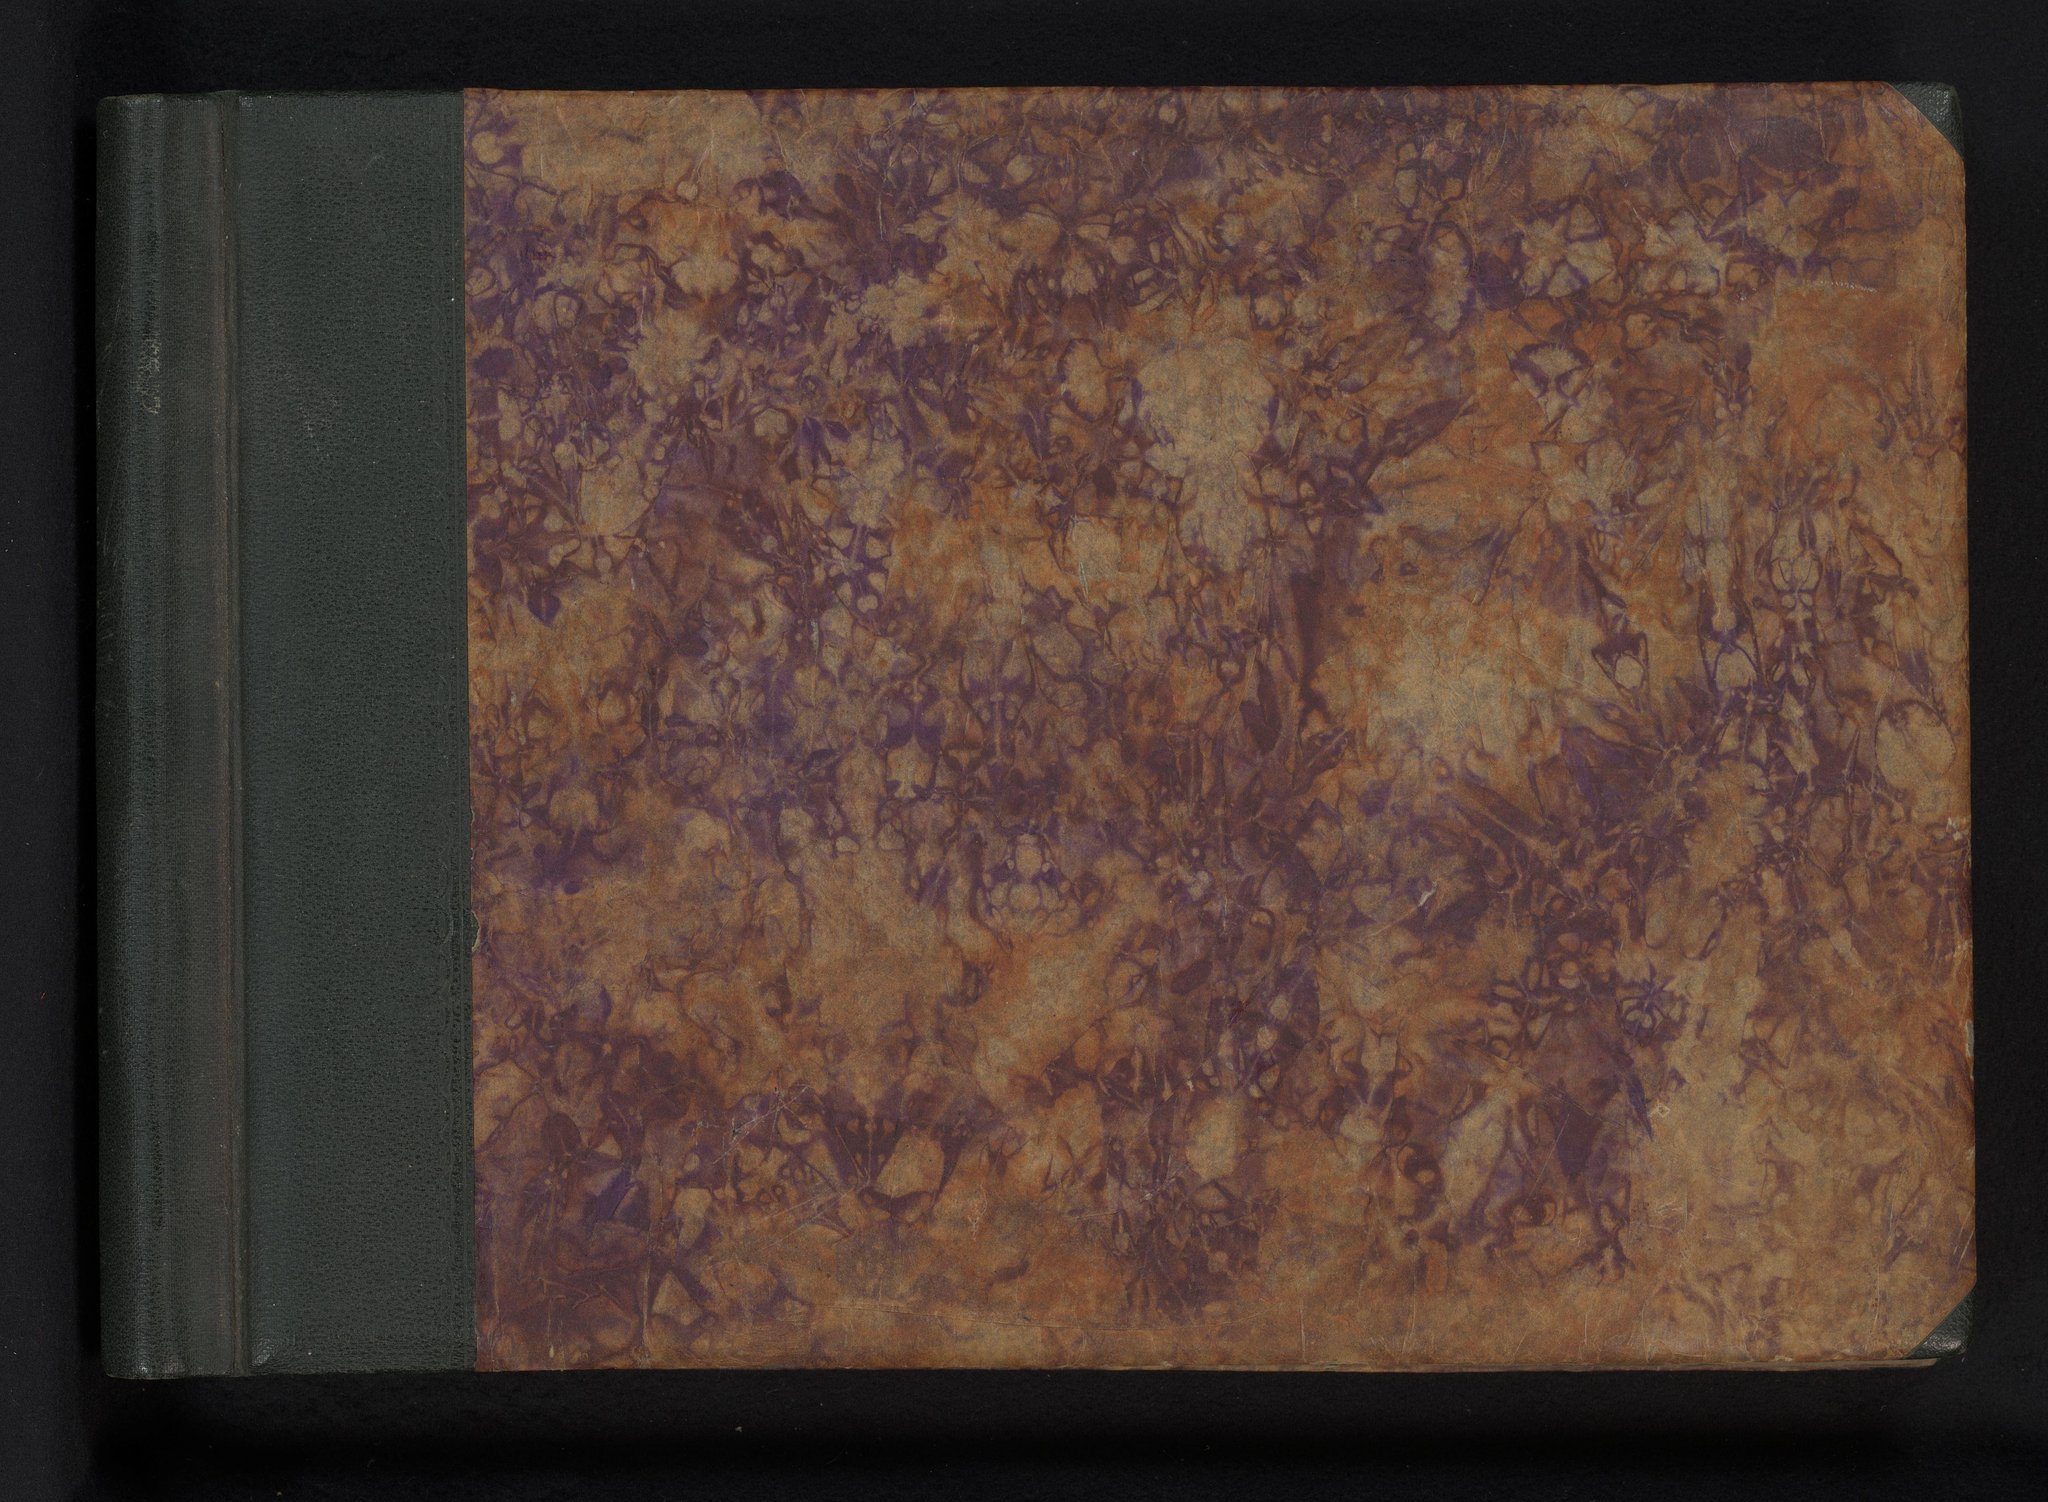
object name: slip in album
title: Fotoalbum (leeg)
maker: Anonymous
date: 1860-1930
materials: cardboard, leather, paper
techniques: marbling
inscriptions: collector's mark: ‘DIENST/ VERSPREIDE/ RIJKSKOLLEKTIES/ (...) A 1011’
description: Fotoalbum met 24 pagina's met ieder 4 passe-partouts met het formaat 80 mm bij 110 mm. In totaal is er in het album plaats voor 96 foto's.